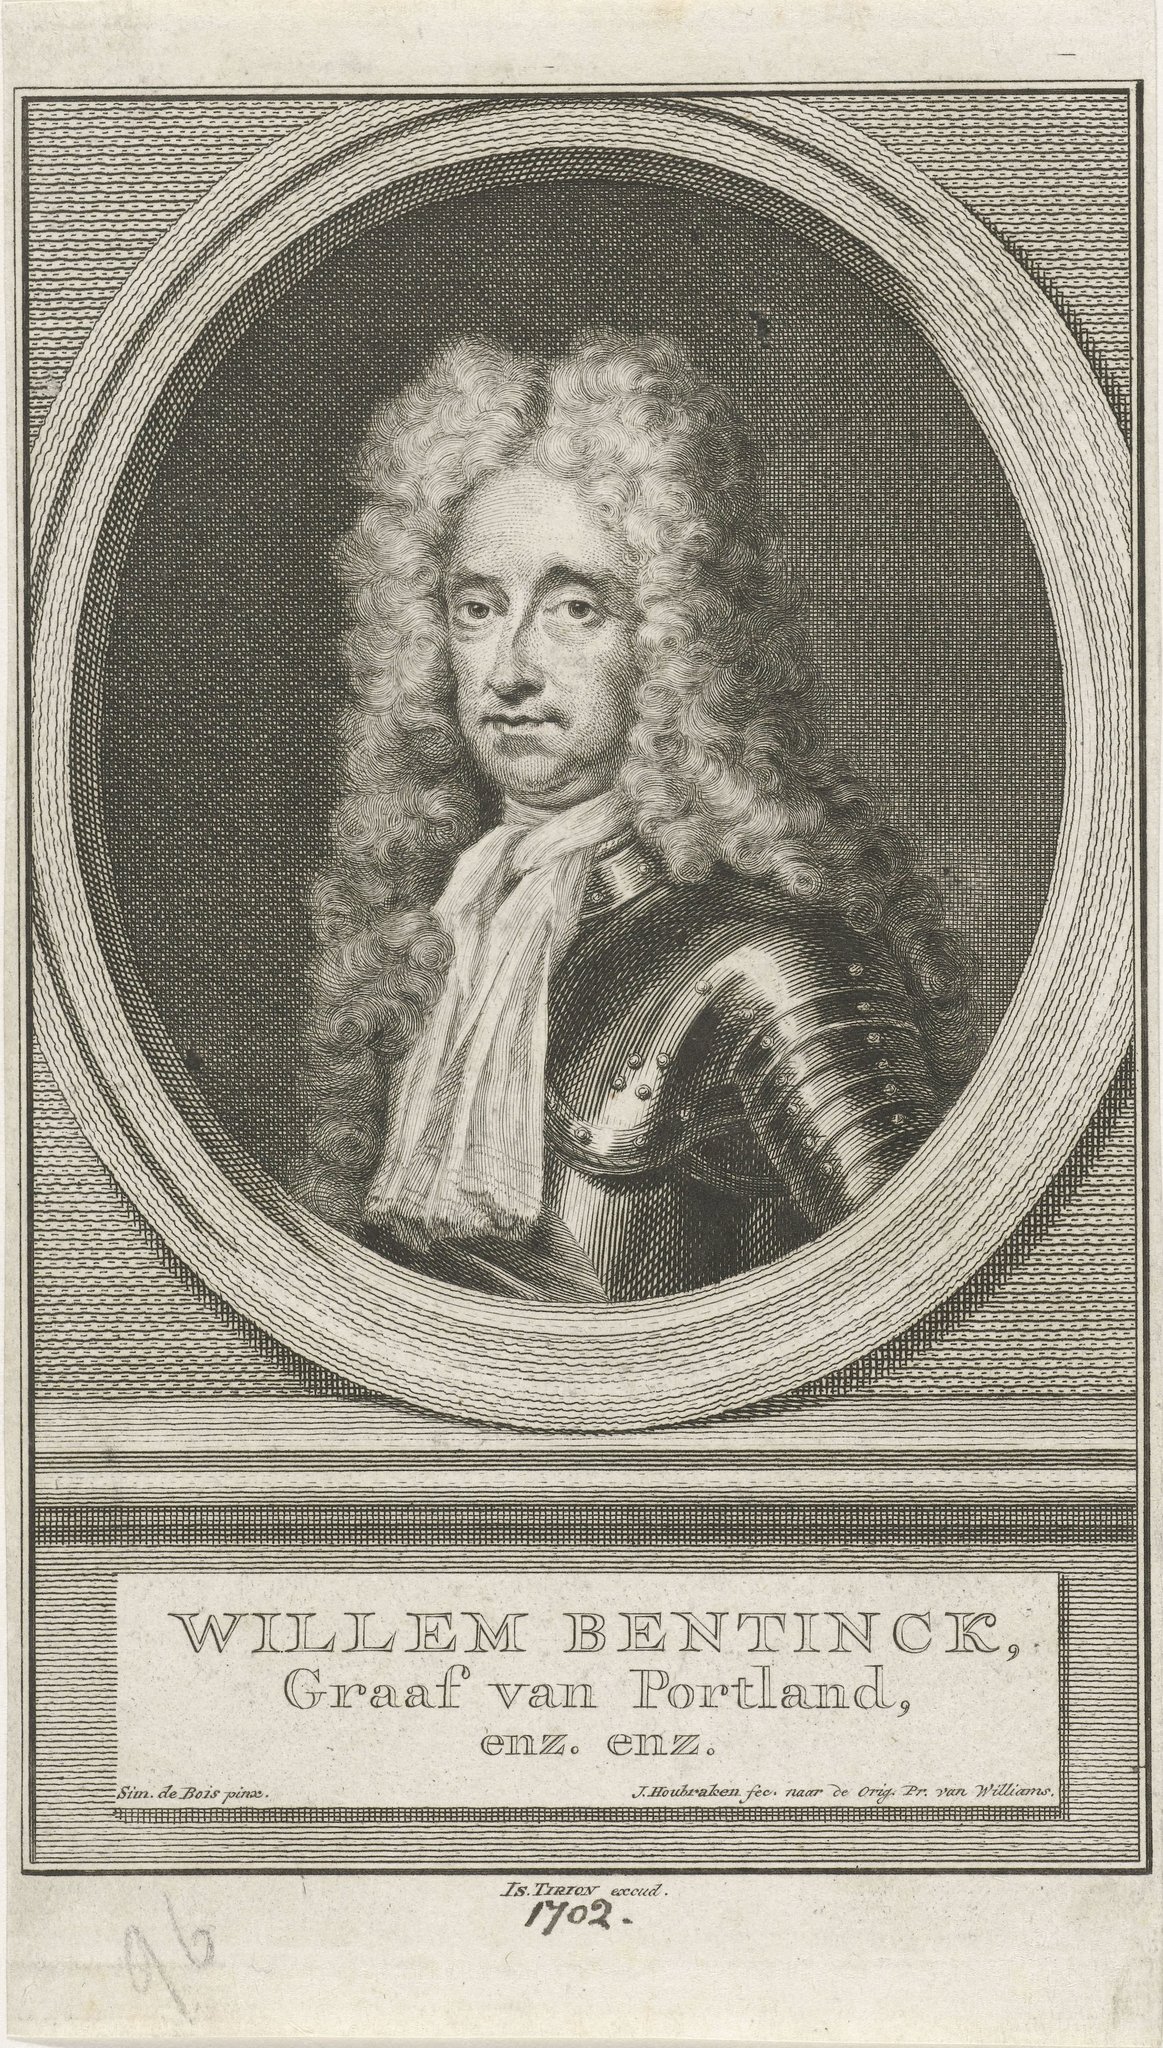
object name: print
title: Portret van Hans Willem Bentinck, graaf van Portland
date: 1749-1759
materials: paper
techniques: engraving, etching, pen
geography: amsterdam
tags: earl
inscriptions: collector's mark: Lugt 2228, inscription: ‘1702’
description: Prent ook gebruikt in: Jan Wagenaar, Vaderlandsche historie, vervattende de geschiedenissen der nu Vereenigde Nederlanden, inzonderheid die van Holland (...), 21 delen. Amsterdam, Isaak Tirion, 1749-59.